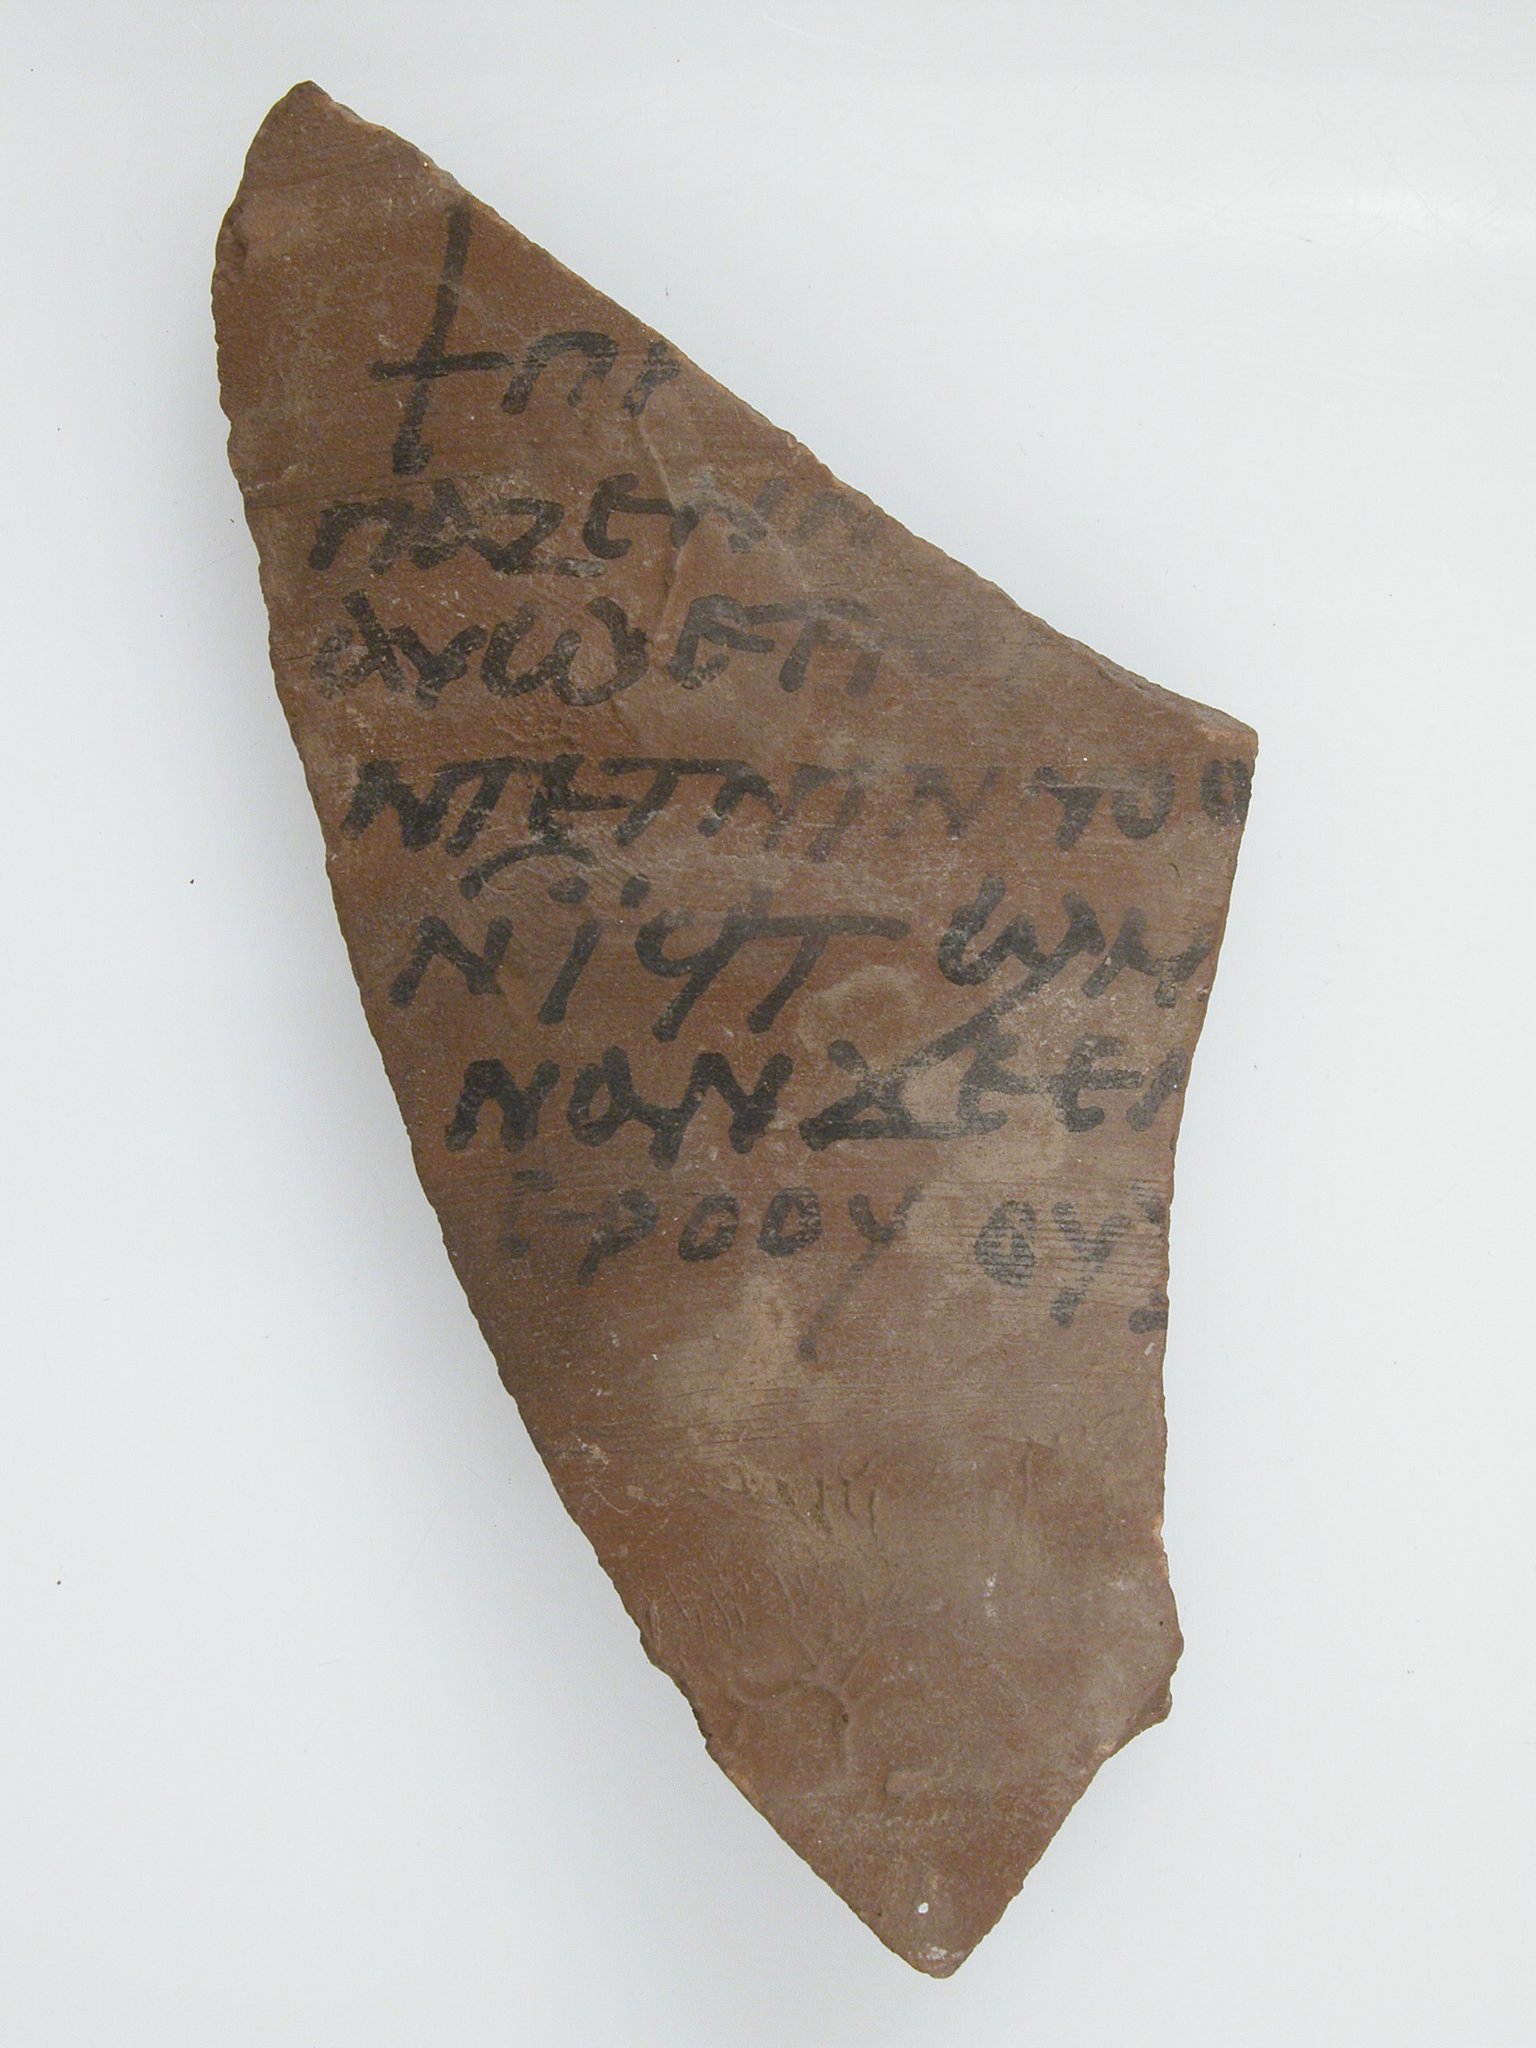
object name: ostrakon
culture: coptic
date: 601-700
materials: ink, pottery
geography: egypt